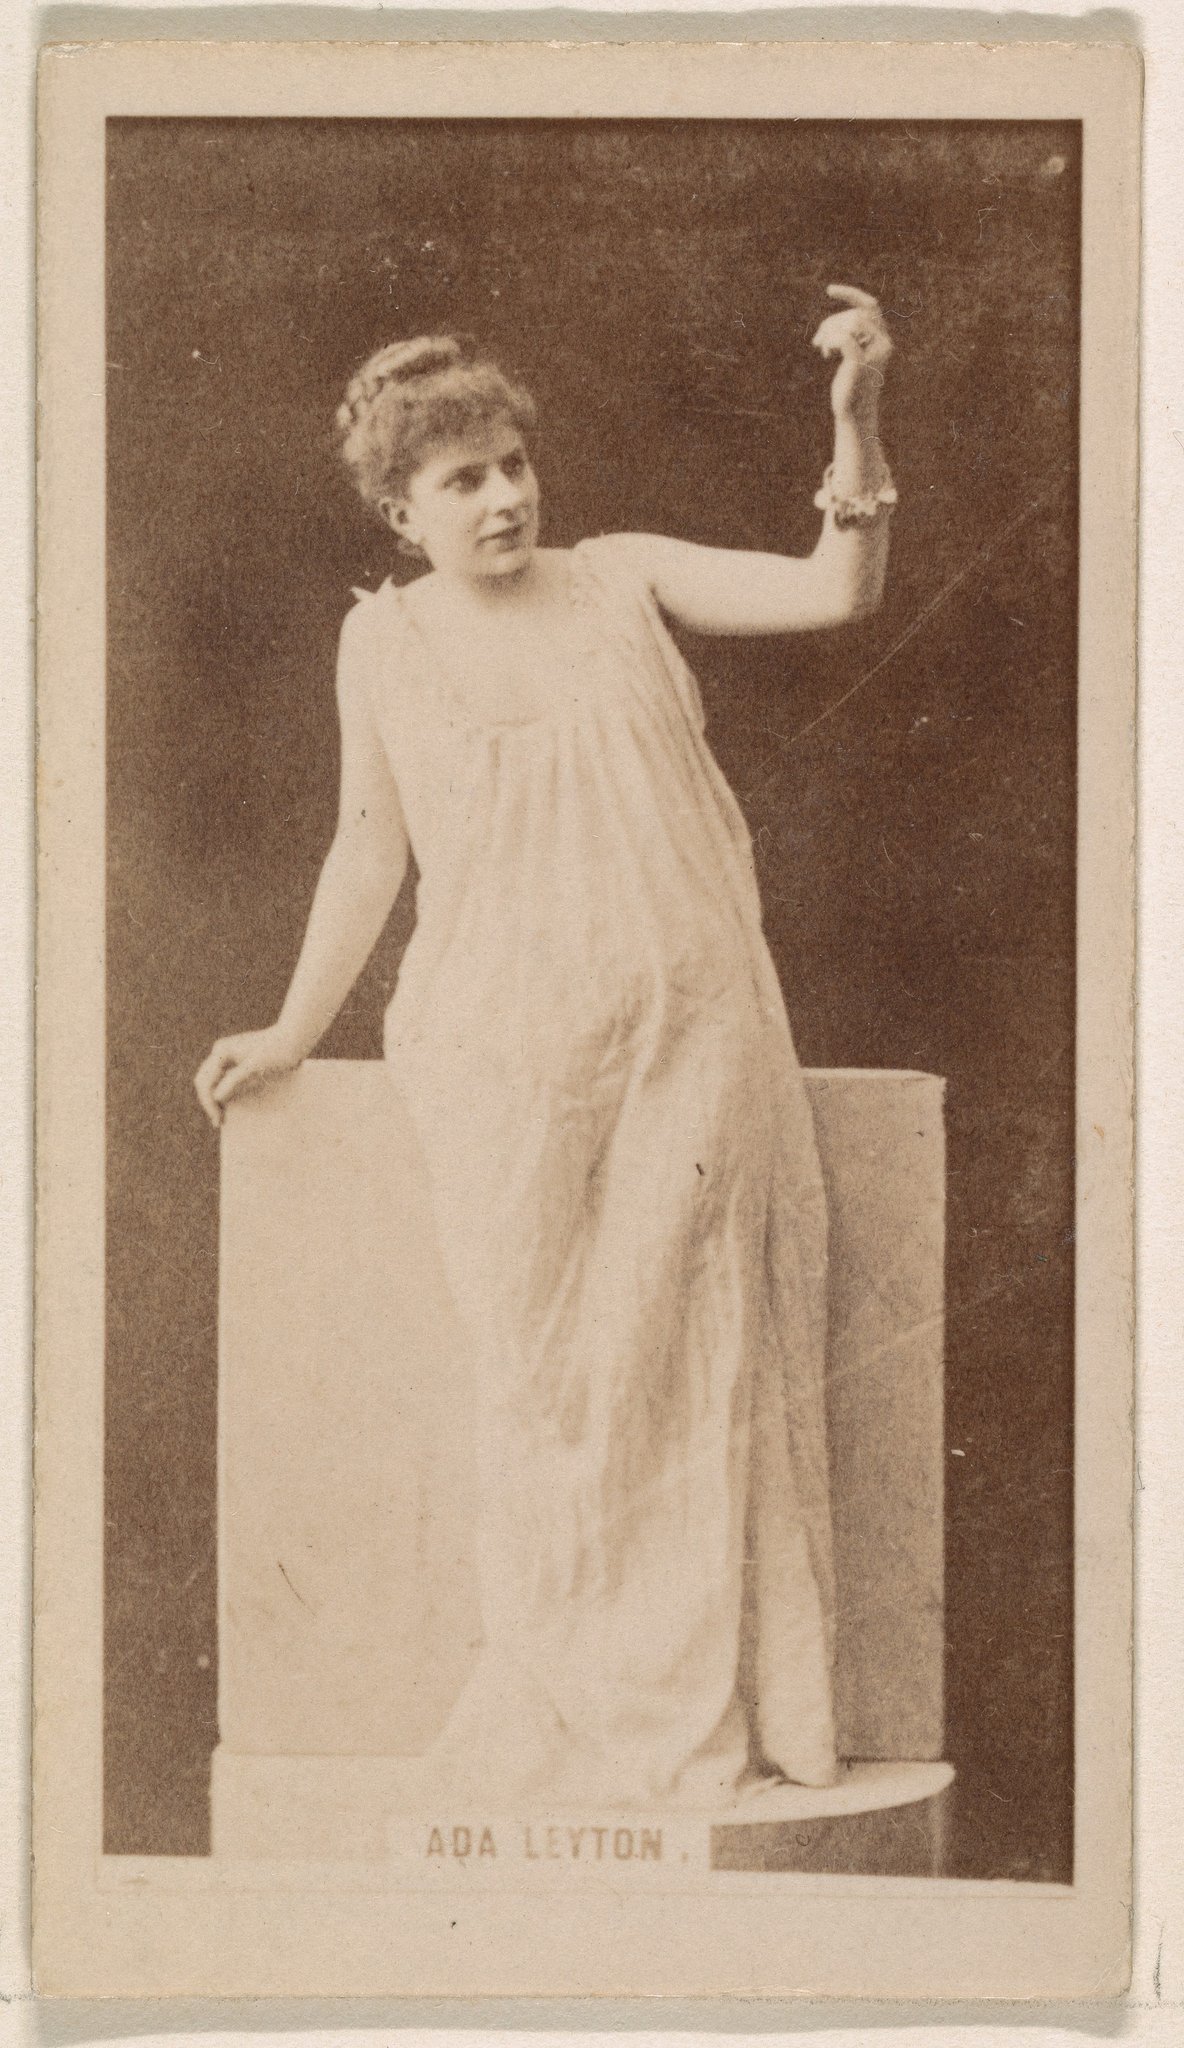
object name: photograph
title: Ada Leyton, from the Actresses series (N245) issued by Kinney Brothers to promote Sweet Caporal Cigarettes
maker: kinney brothers tobacco company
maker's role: publisher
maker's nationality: american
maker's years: 1869-2011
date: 1890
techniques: albumen silver print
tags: portraits,women,actresses